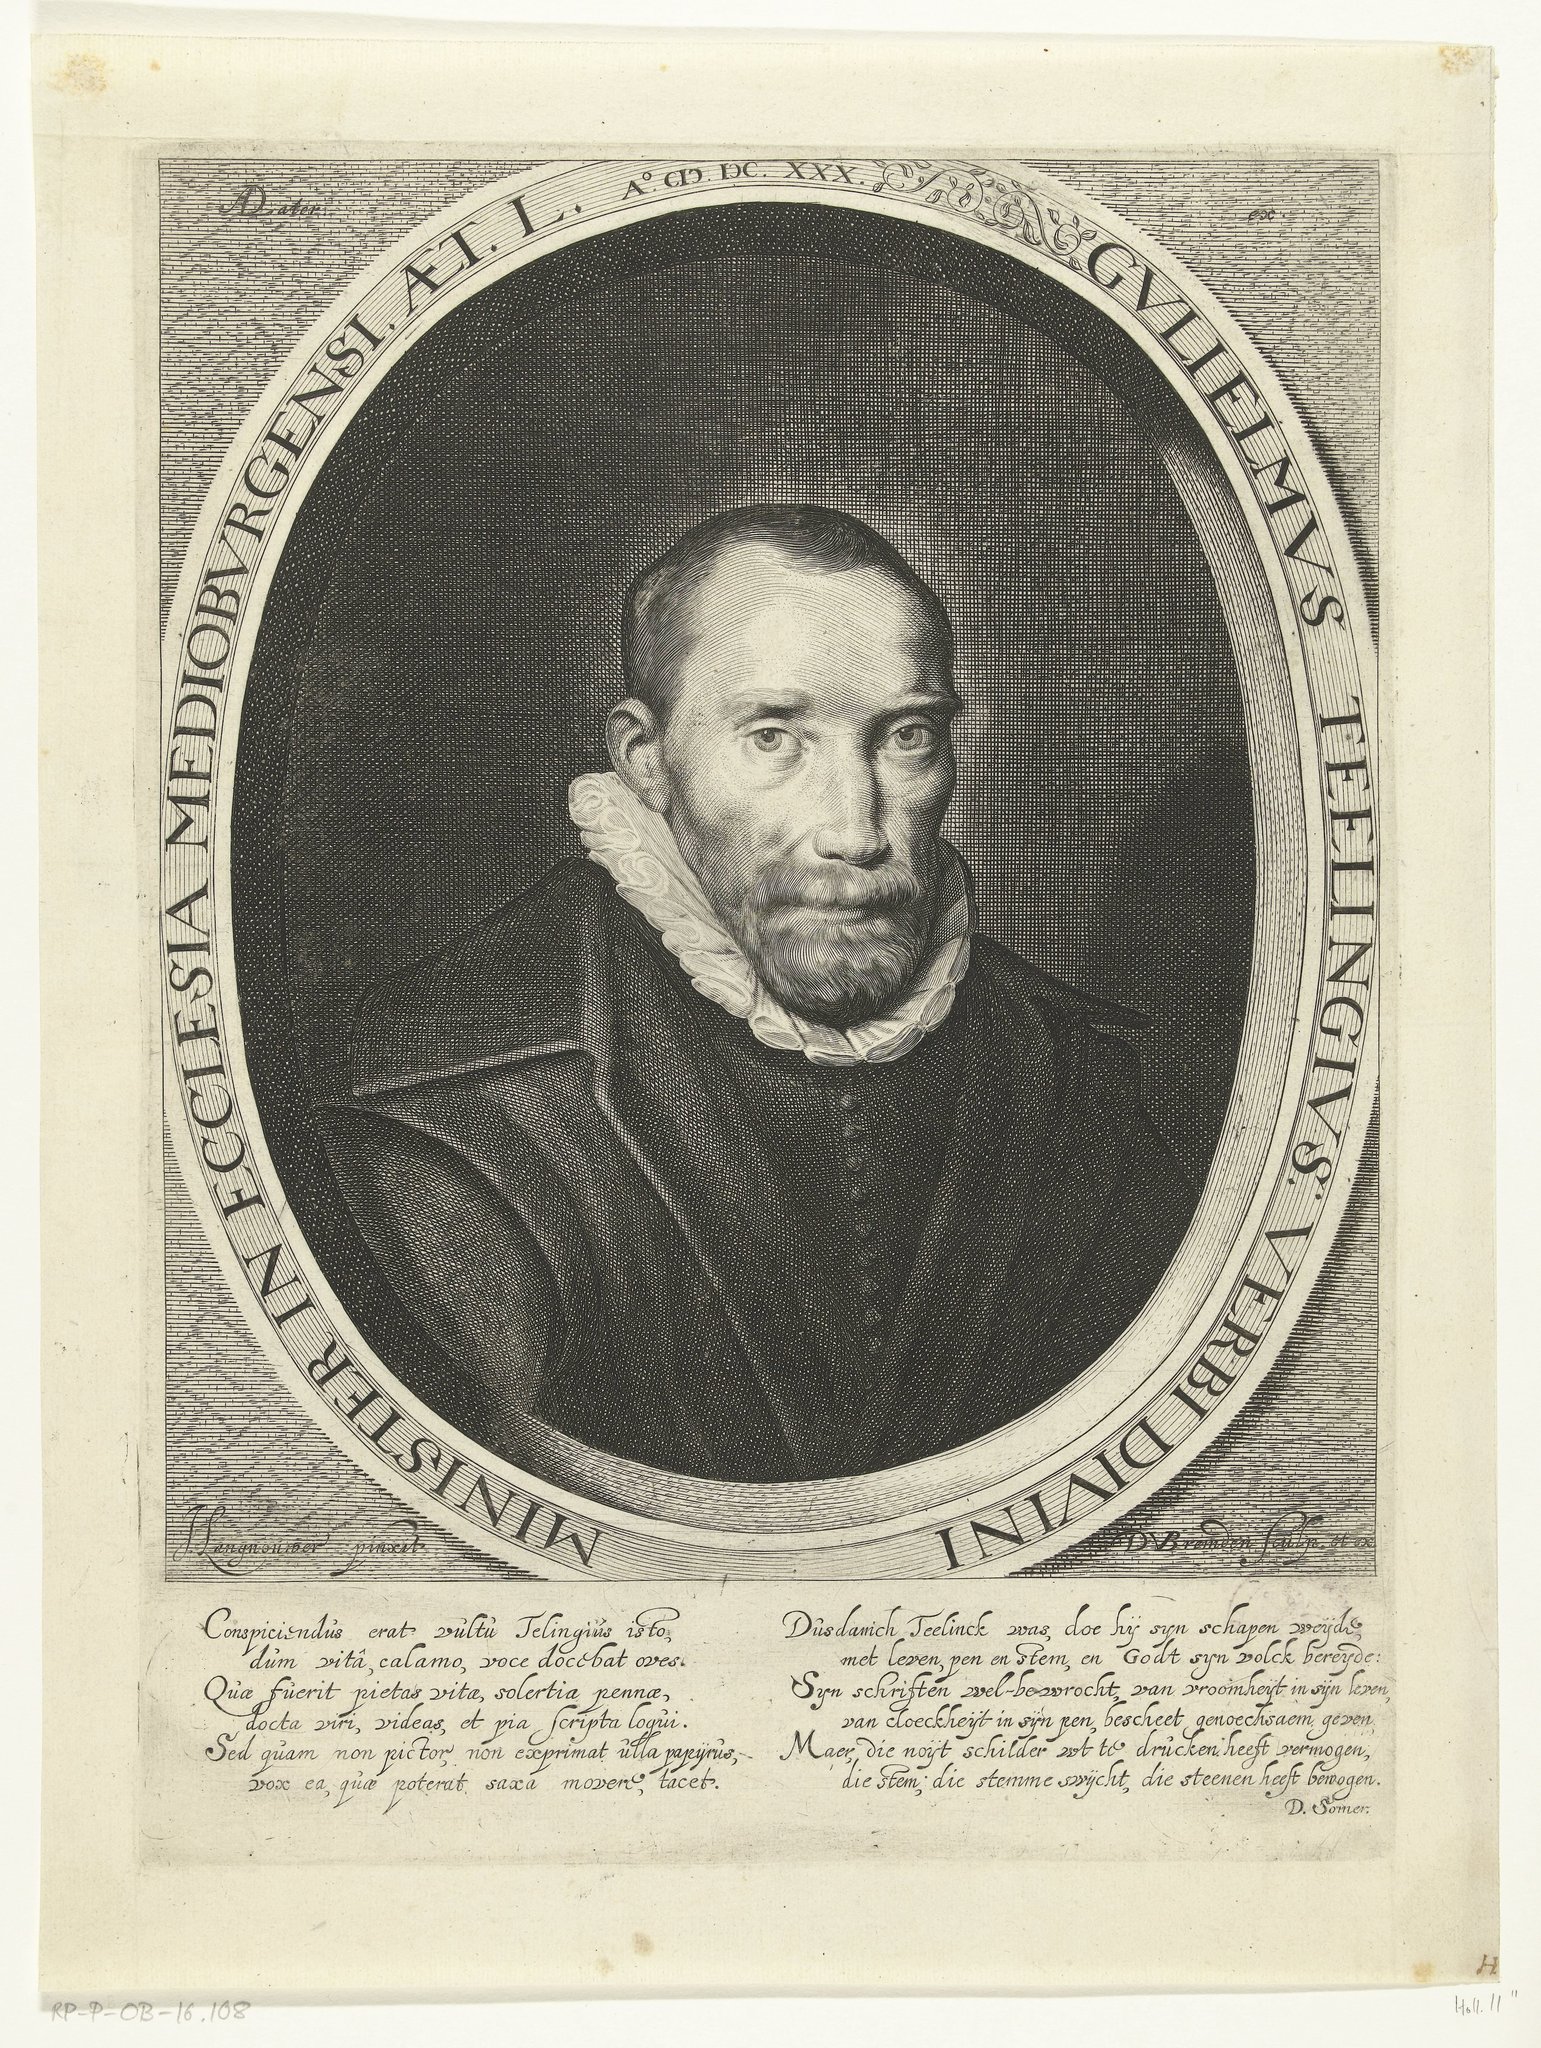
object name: print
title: Portret van Willem Teelinck op 50-jarige leeftijd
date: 1630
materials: paper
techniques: engraving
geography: middelburg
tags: middelburg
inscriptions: collector's mark: Lugt 240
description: Borstbeeld van de theoloog Willem Teelinck, in ovaal met randschrift. Onder het portret een Latijns vers van D. Somer en de Nederlandse vertaling ervan.